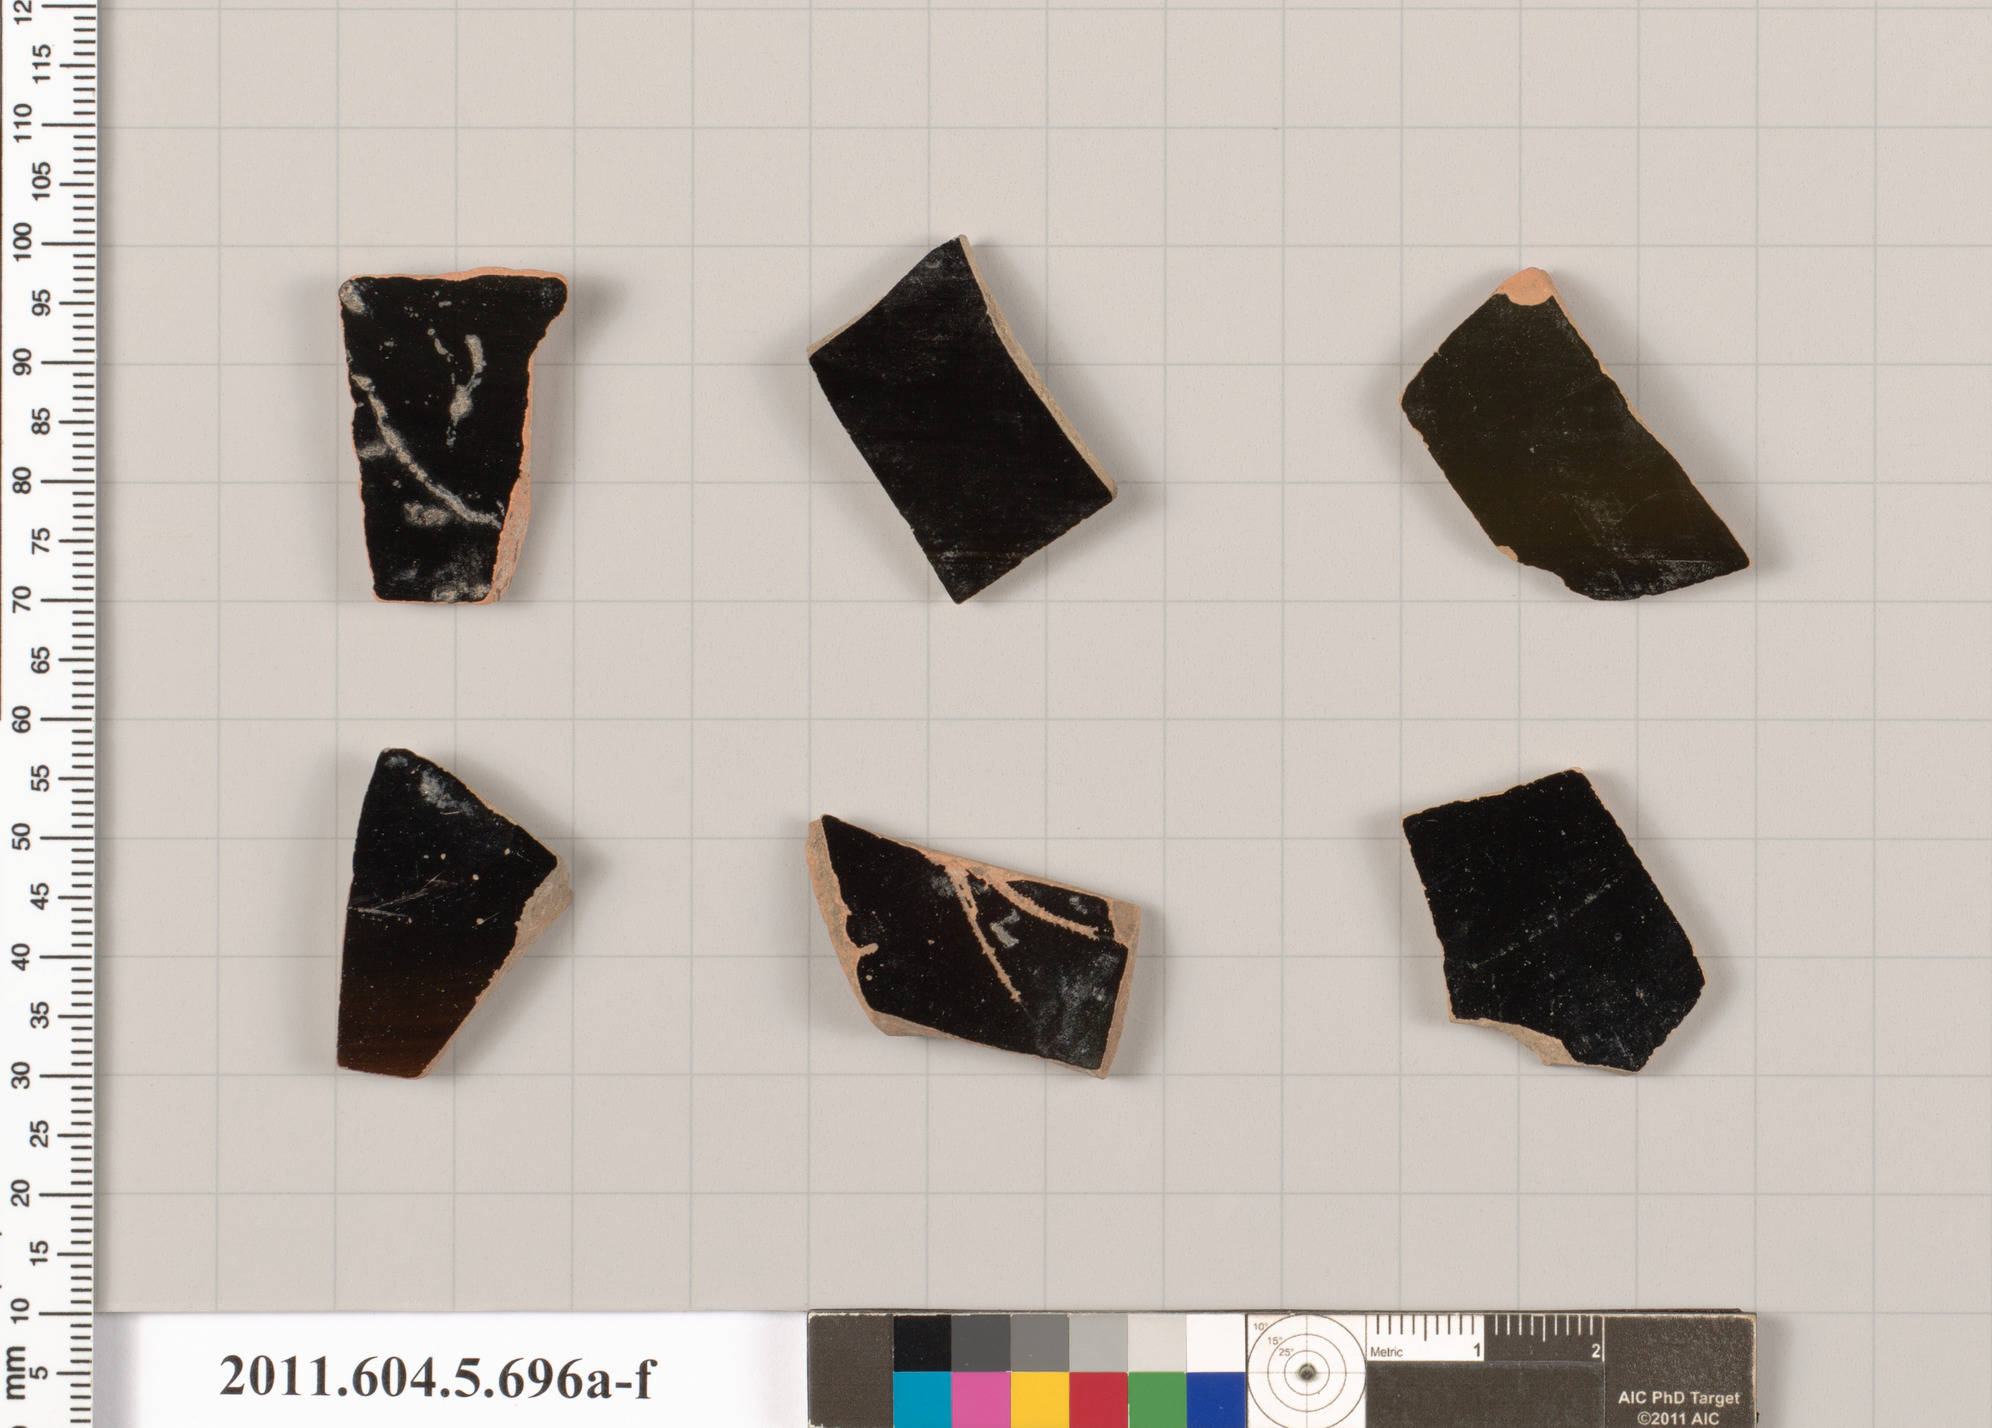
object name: kylix fragment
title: Terracotta fragments of kylikes (drinking cups)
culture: greek, attic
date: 600-401 BCE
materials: terracotta